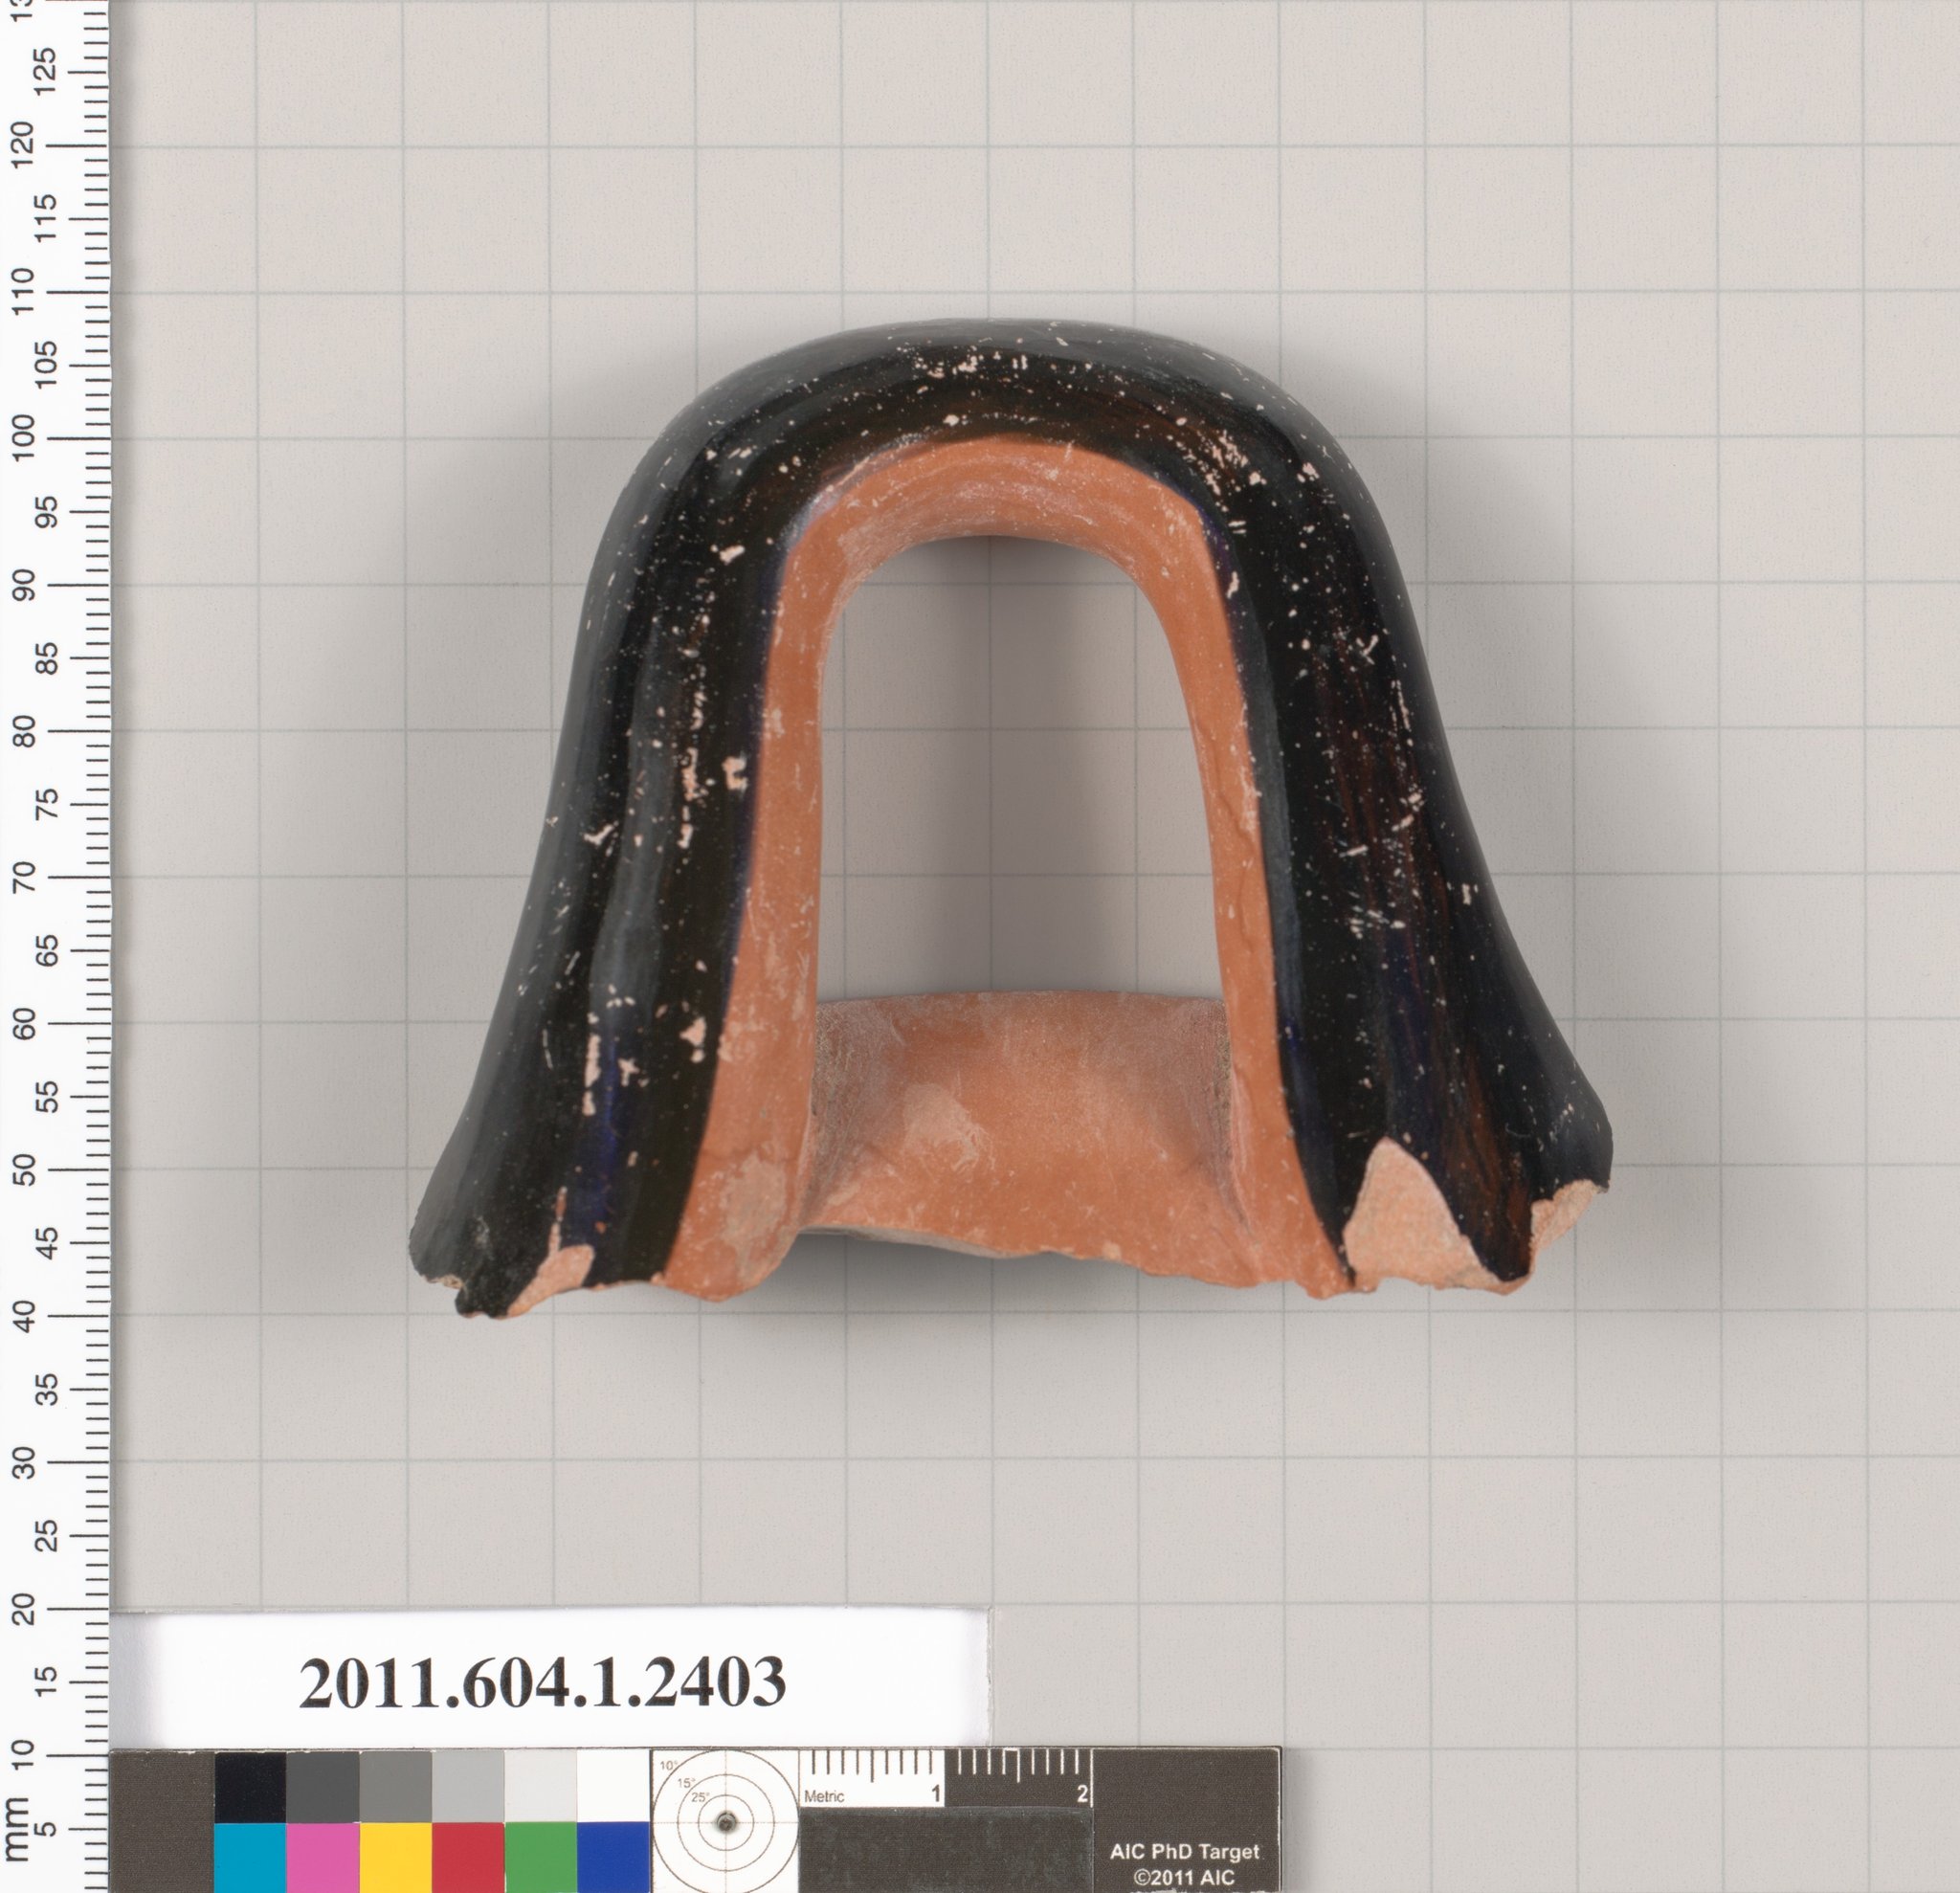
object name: kylix fragment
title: Terracotta fragment of a kylix (drinking cup)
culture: greek, attic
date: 500-401 BCE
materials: terracotta